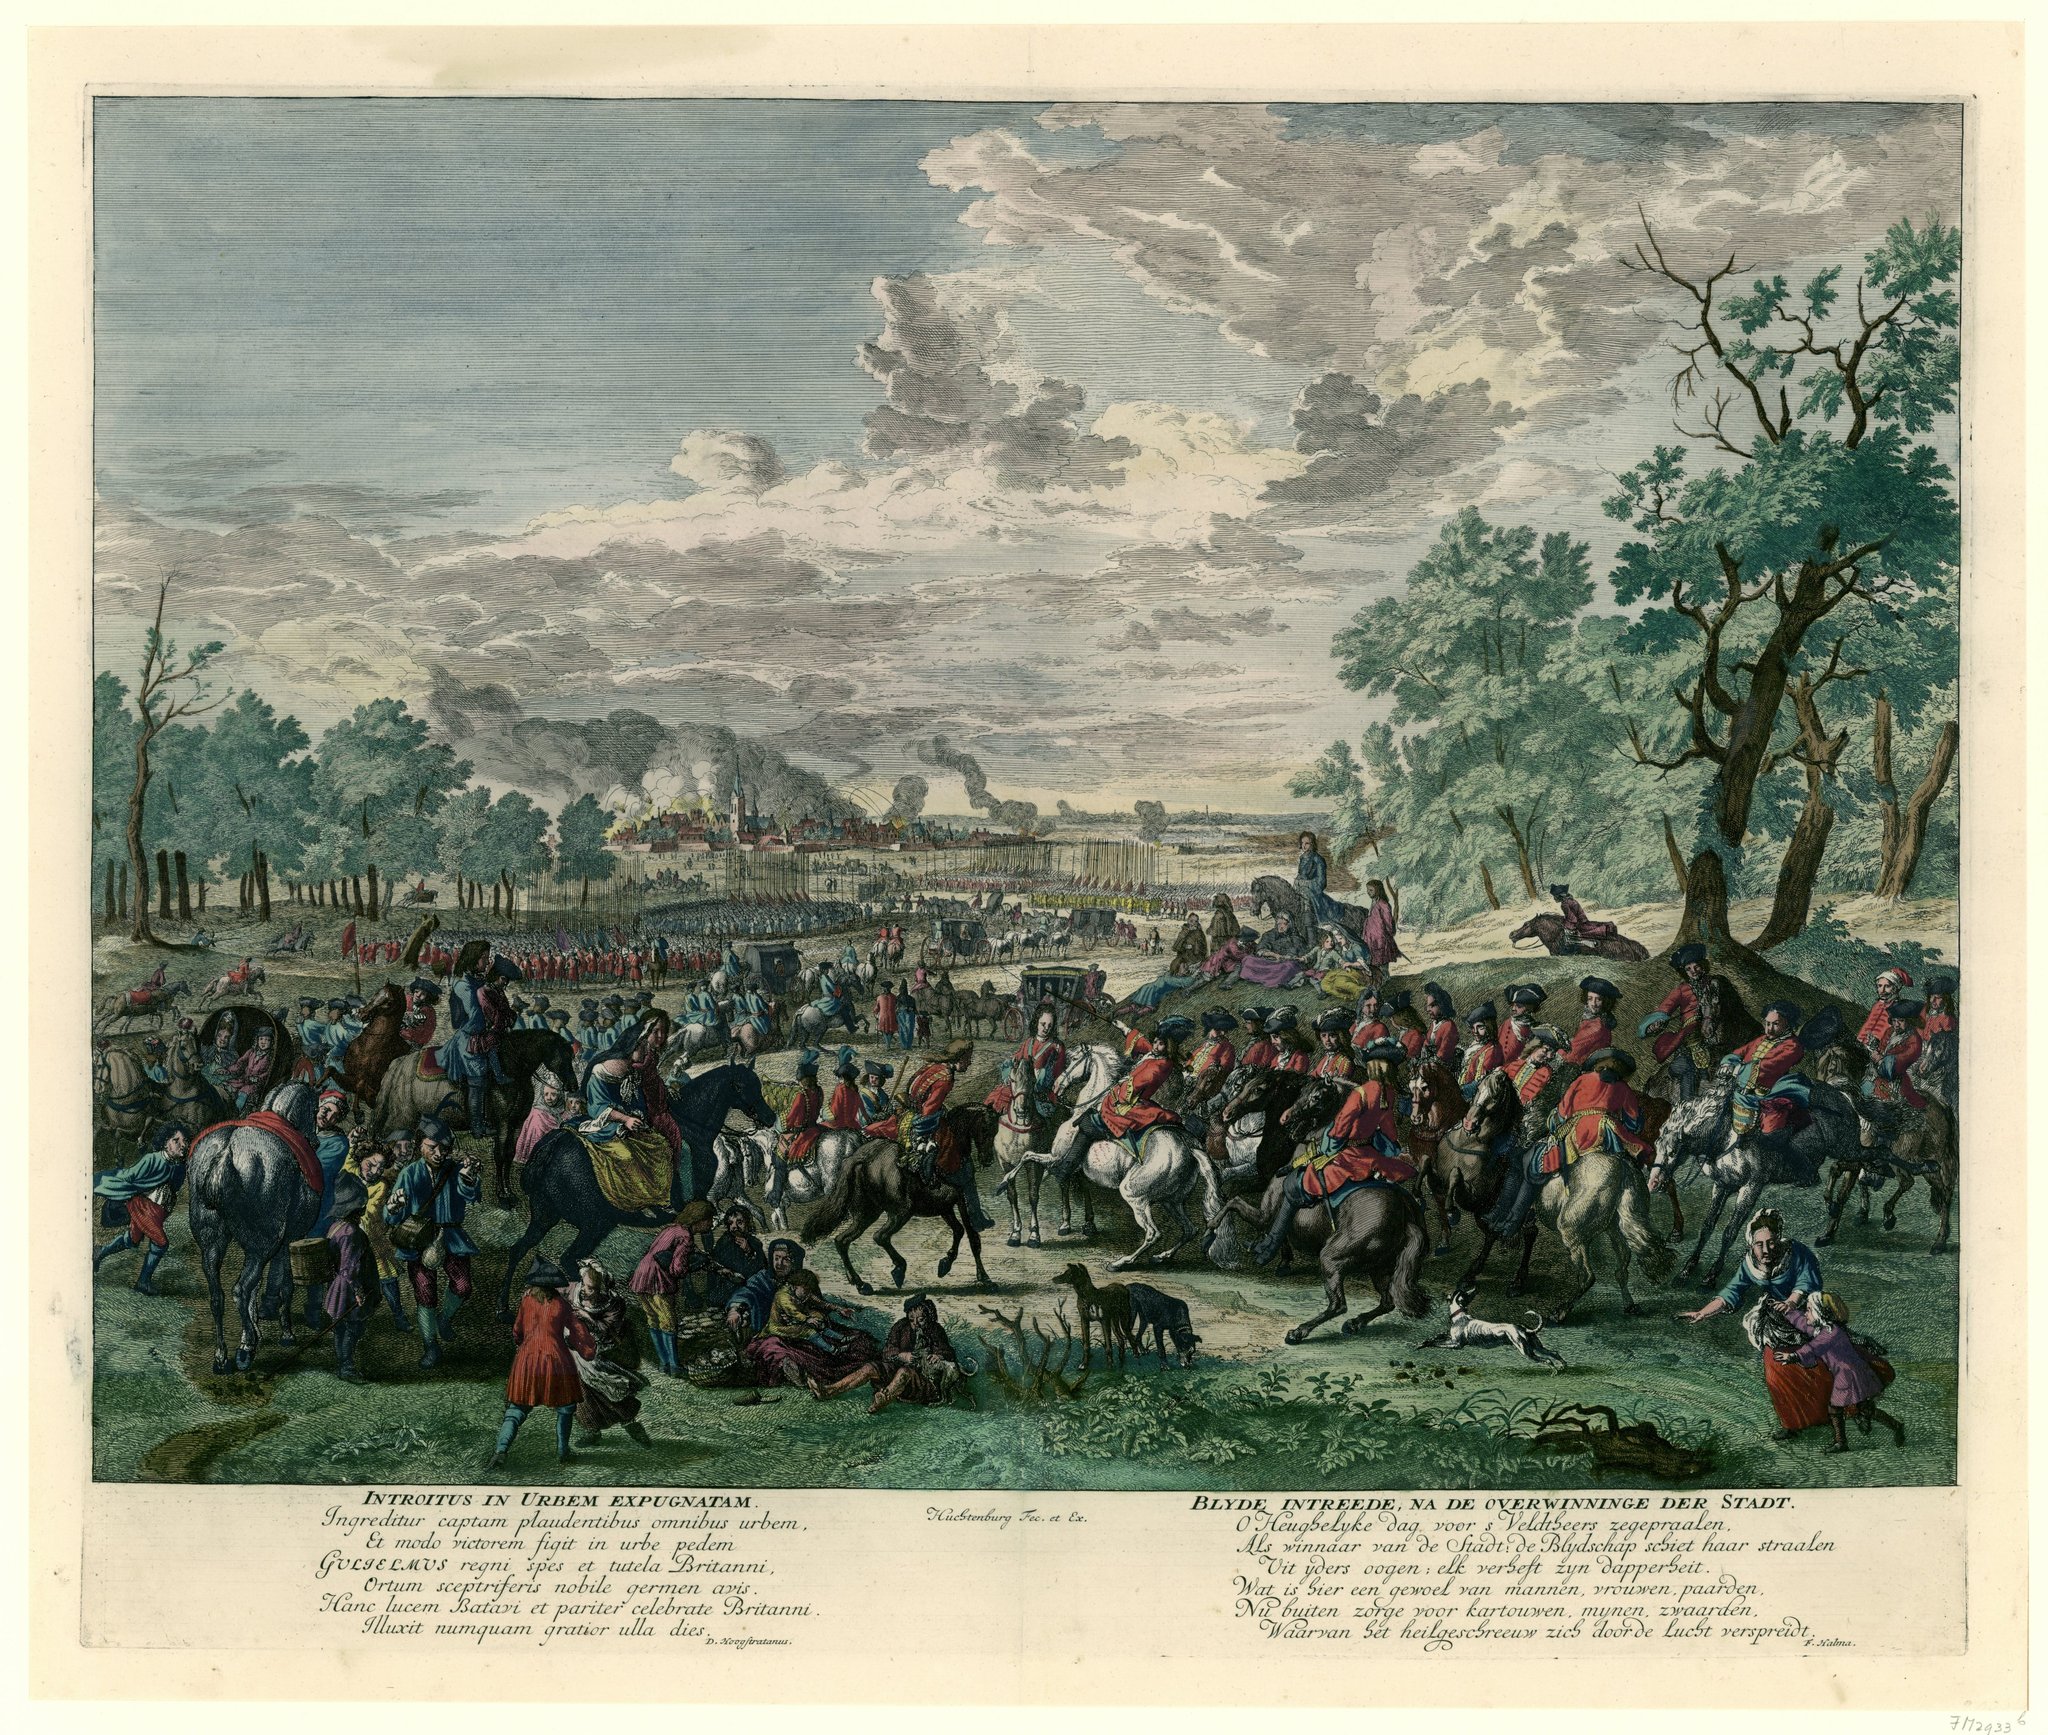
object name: print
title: Introitus in urbem expugnatam / Blyde Intreede, na de overwinninge der stadt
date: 1695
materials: paper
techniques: etching, hand coloring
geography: northern netherlands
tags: the hague, william iii (prince of orange and king of england, scotland, and ireland), maximiliaan ii emanuel (keurvorst van beieren), march into the conquered place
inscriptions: collector's mark: Lugt 2228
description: De legers van geallieerden maken zich gereed om op 4 augustus 1695 de veroverde stad Namen binnen te trekken. In de verte gaan de beschietingen van de citadel nog door. Onder de voorstelling verzen in het Latijn en Nederlands.